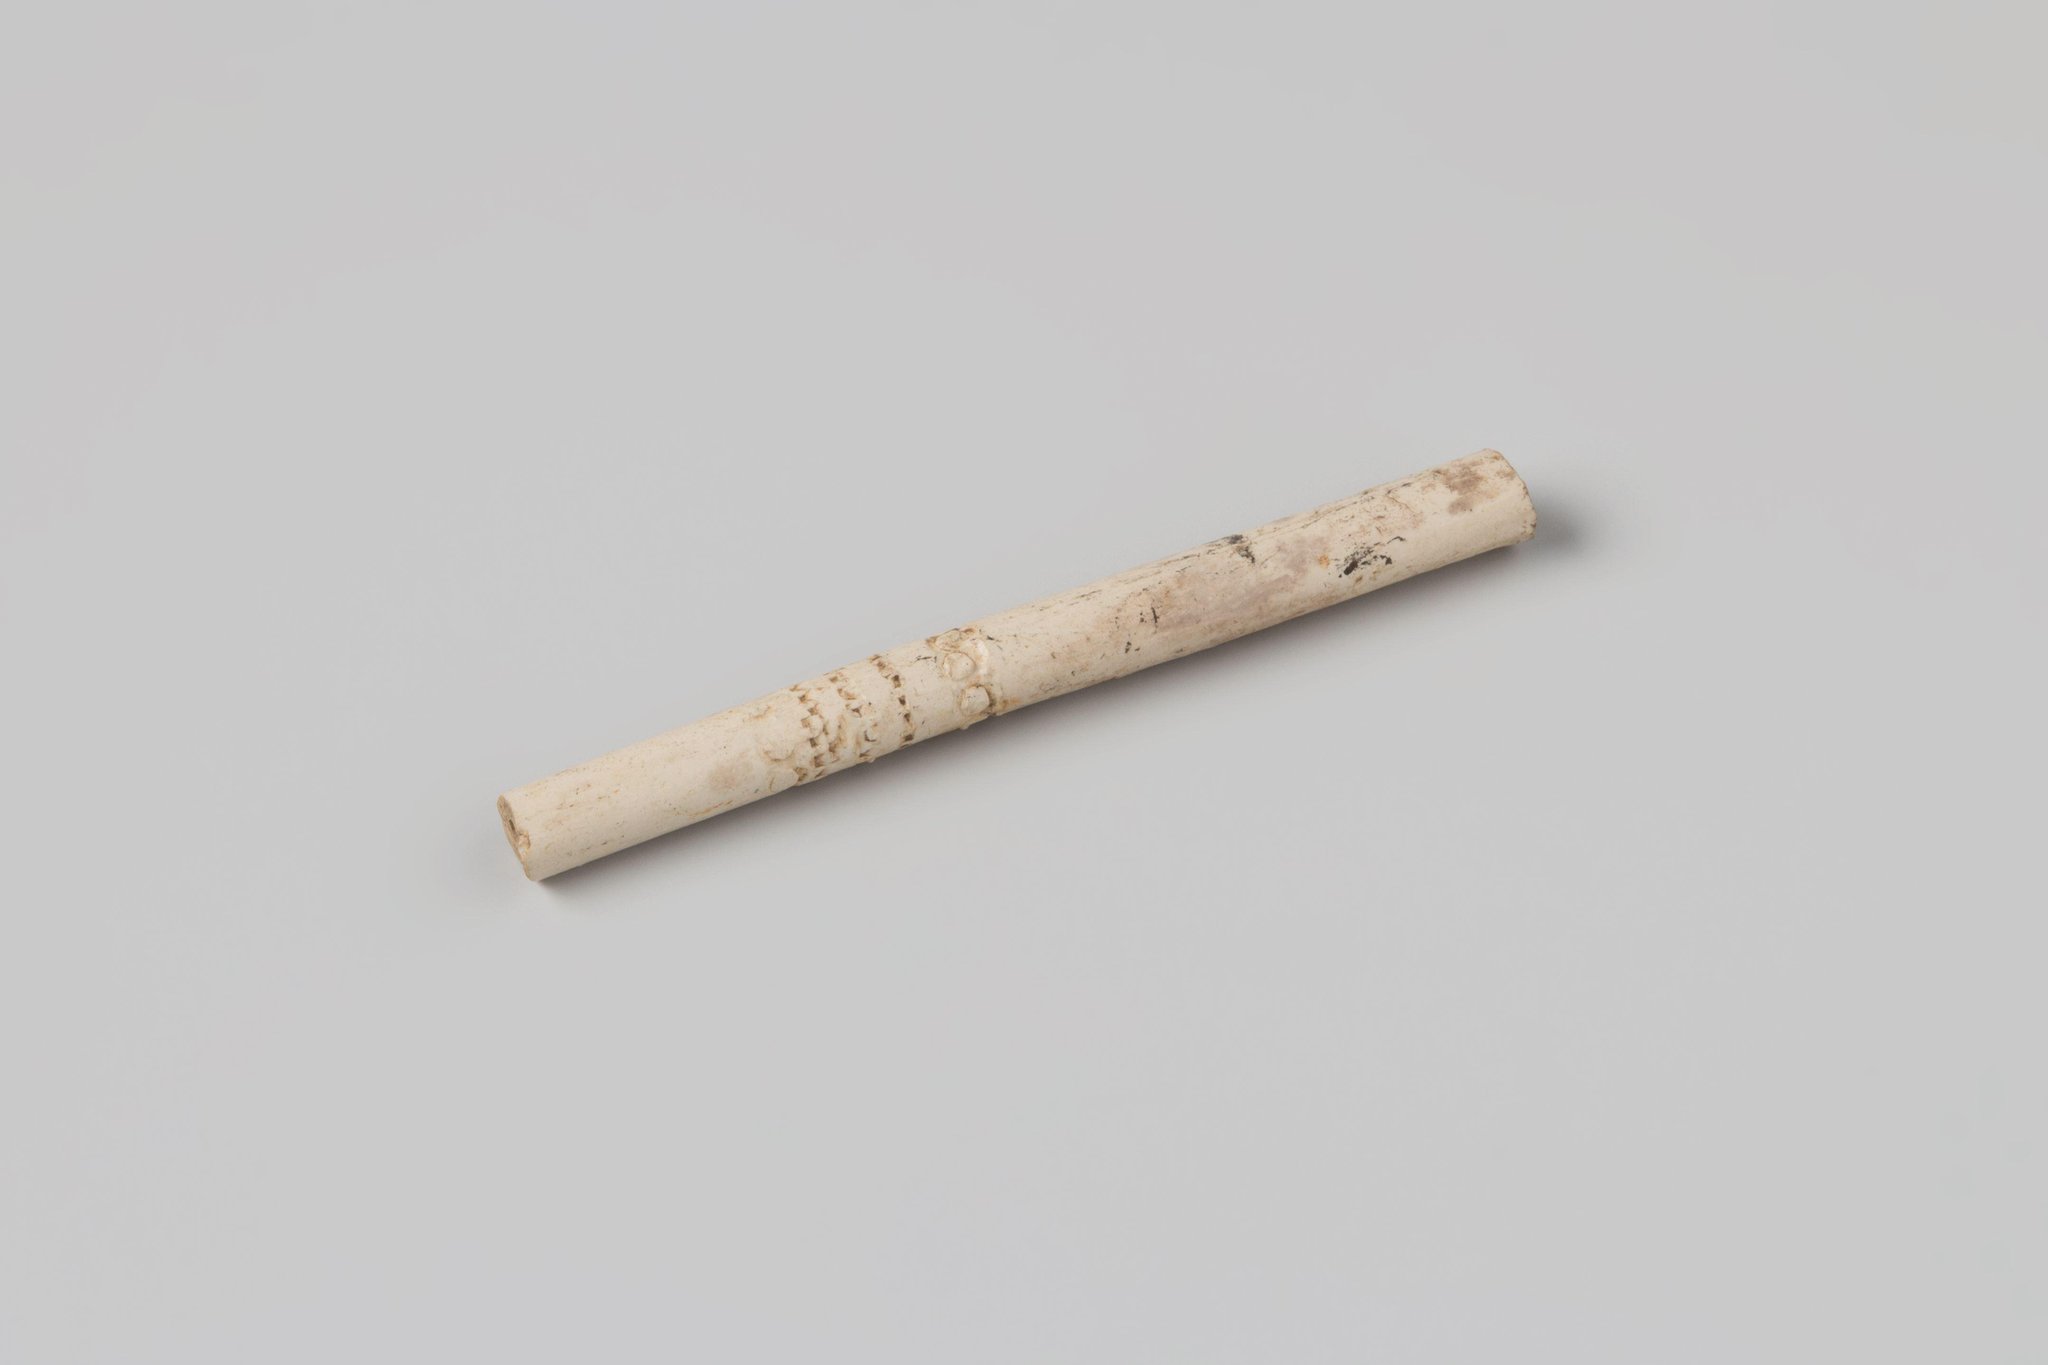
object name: pipe stem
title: Fragment pijpensteel uit het wrak van de Oost-Indiëvaarder Hollandia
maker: Anonymous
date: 1700-1743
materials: clay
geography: netherlands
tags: verenigde oostindische compagnie, hollandia (schip), annet